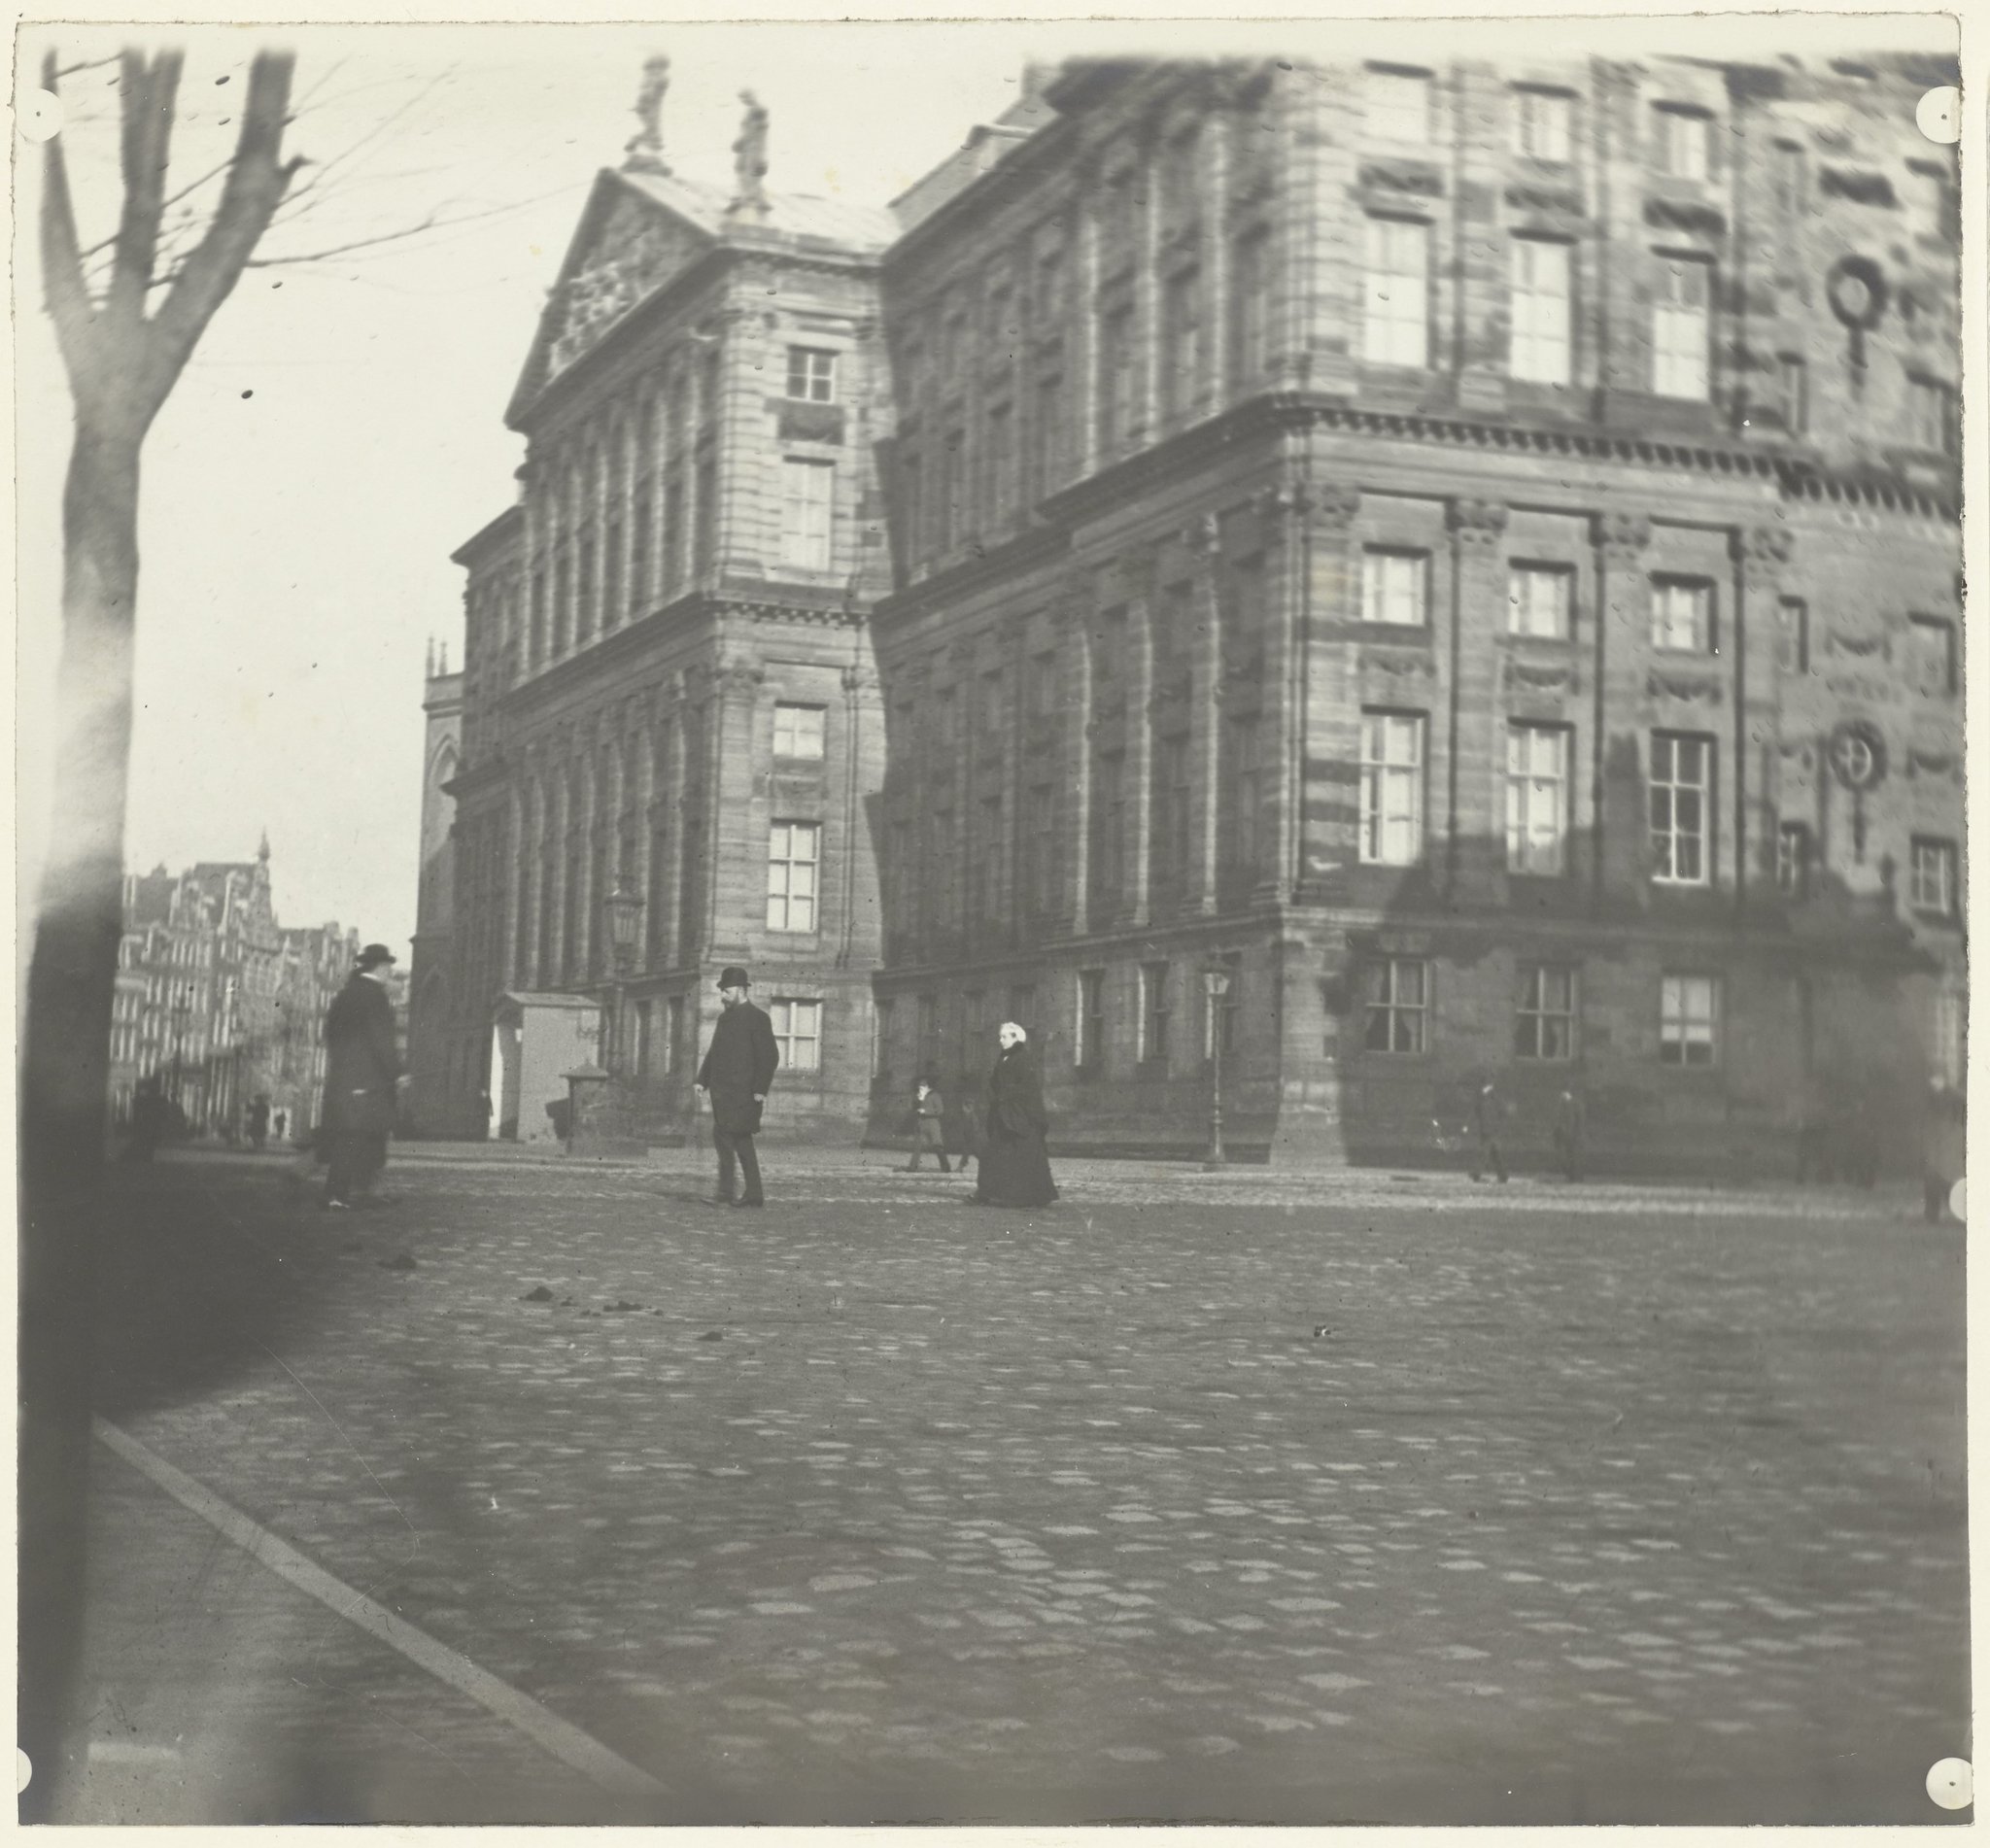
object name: photograph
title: Achterzijde van het Paleis op de Dam in Amsterdam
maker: george hendrik breitner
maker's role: draughtsman, painter, print maker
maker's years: 1857-1923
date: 1886-1910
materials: cardboard, paper, photographic support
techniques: gelatin silver print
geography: amsterdam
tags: palace, street, royal palace of amsterdam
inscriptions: number: ‘neg 14743 18/24’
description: Hoek van de Nieuwezijds Voorburgwal en de Paleisstraat